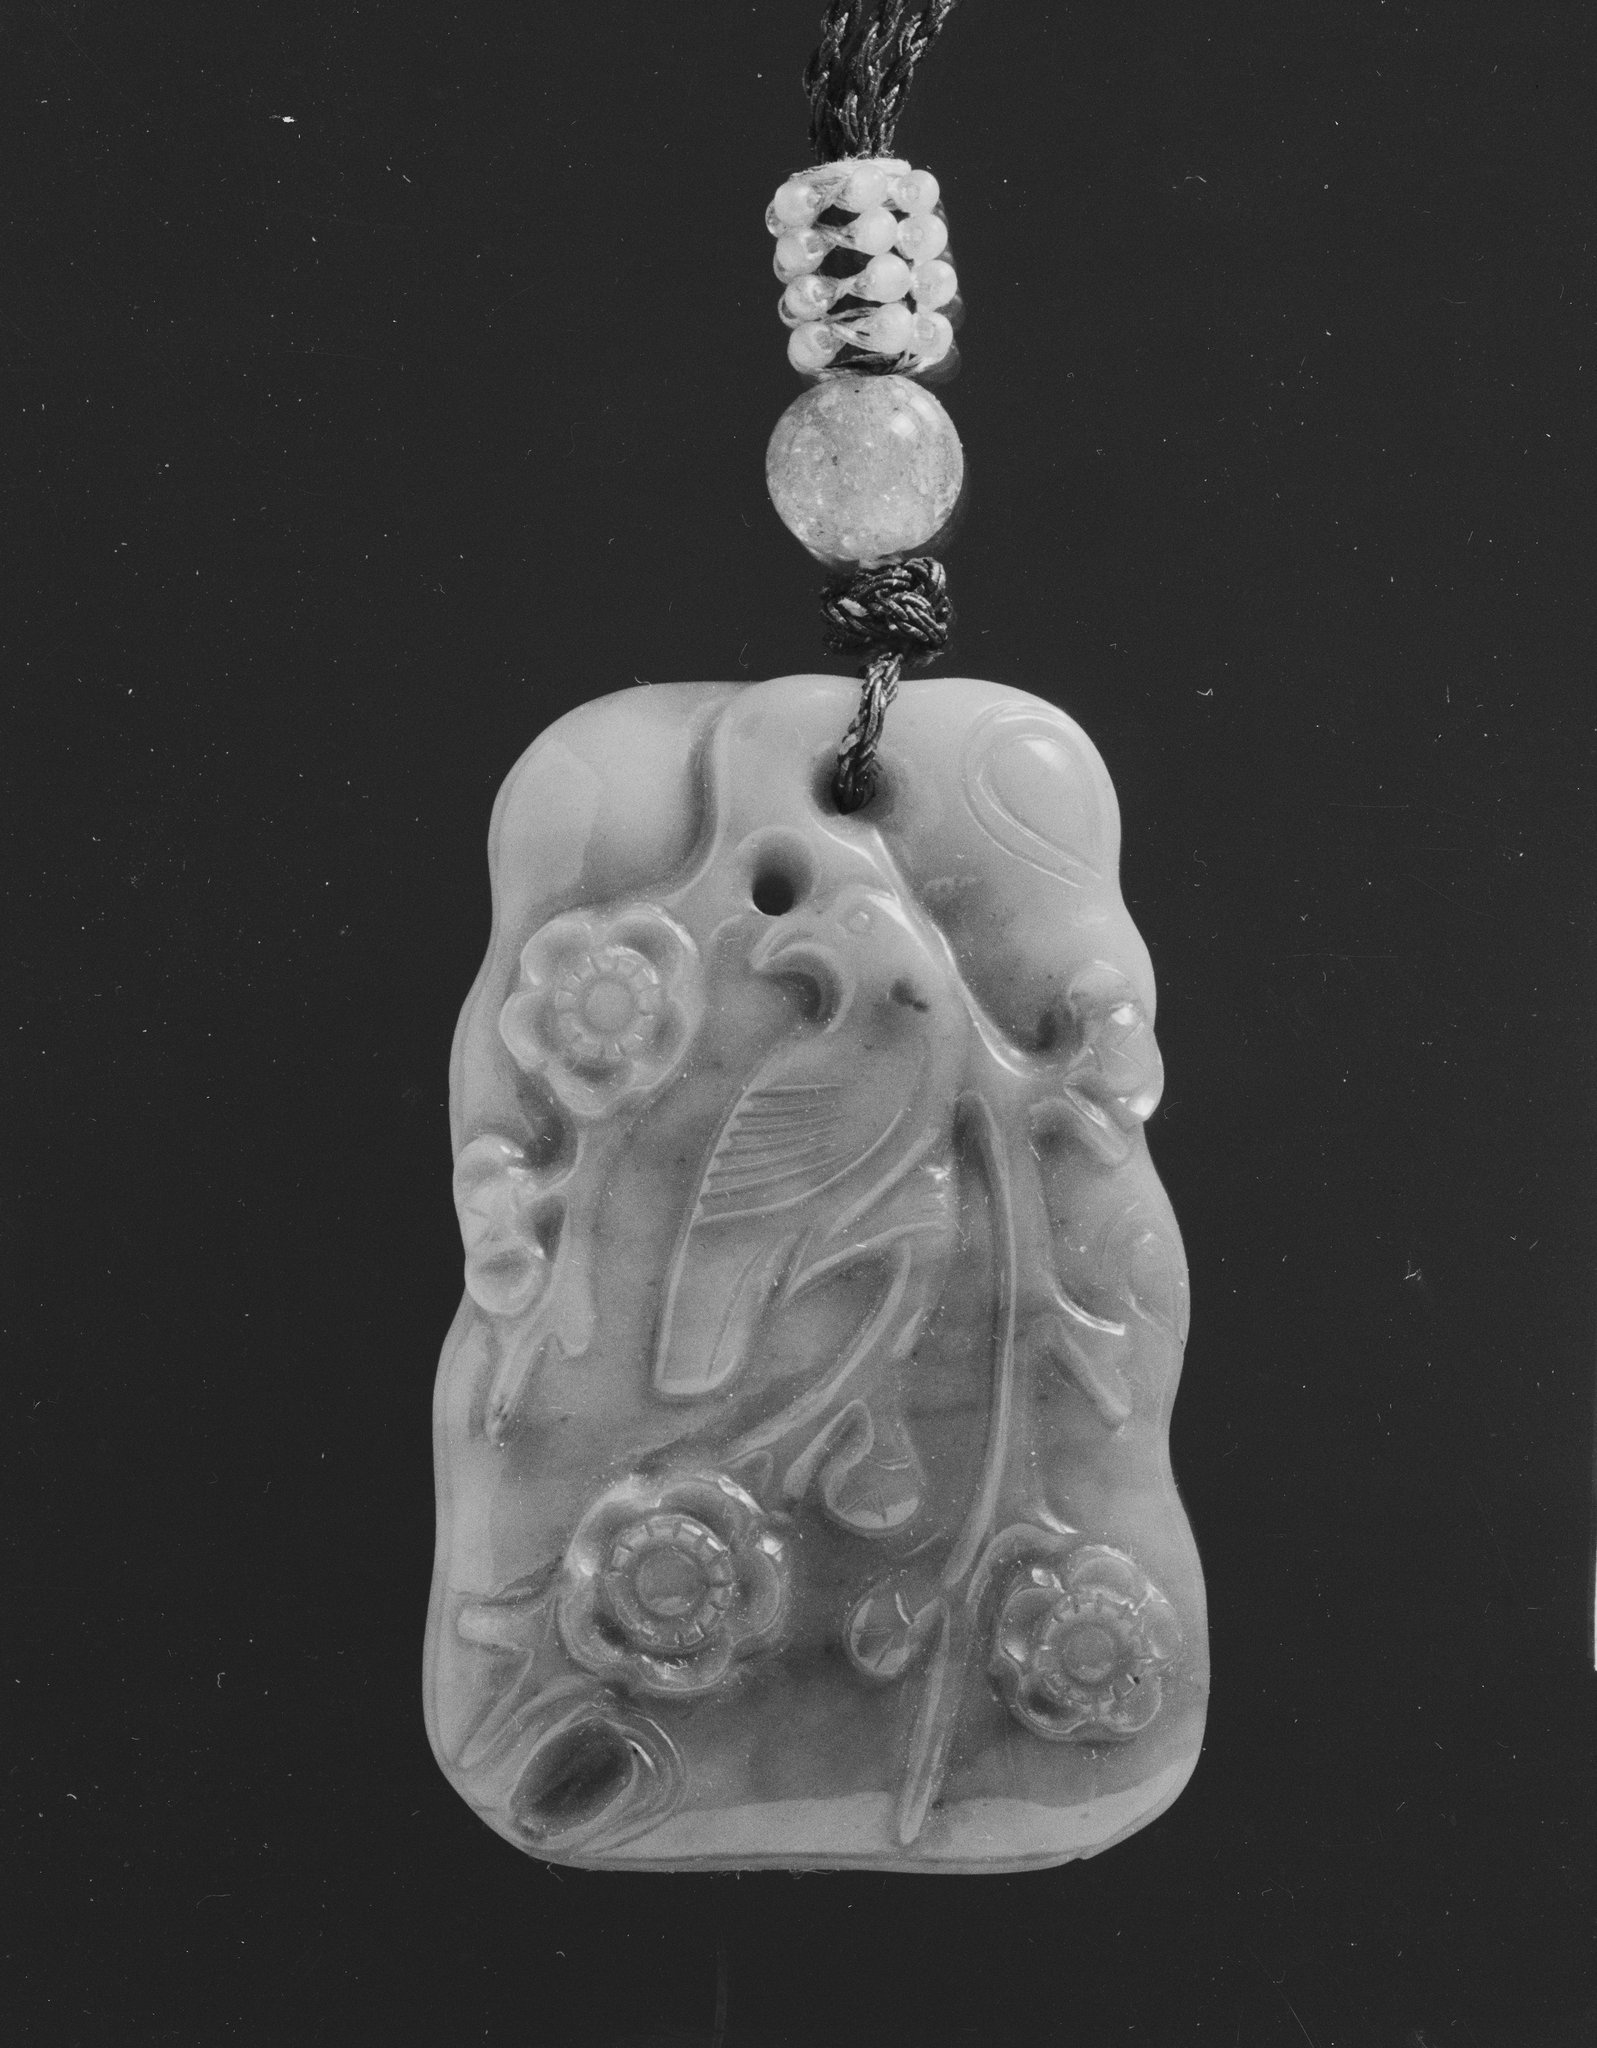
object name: pendant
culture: chinese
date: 1901-2000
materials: jade, pearl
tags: birds,flowers